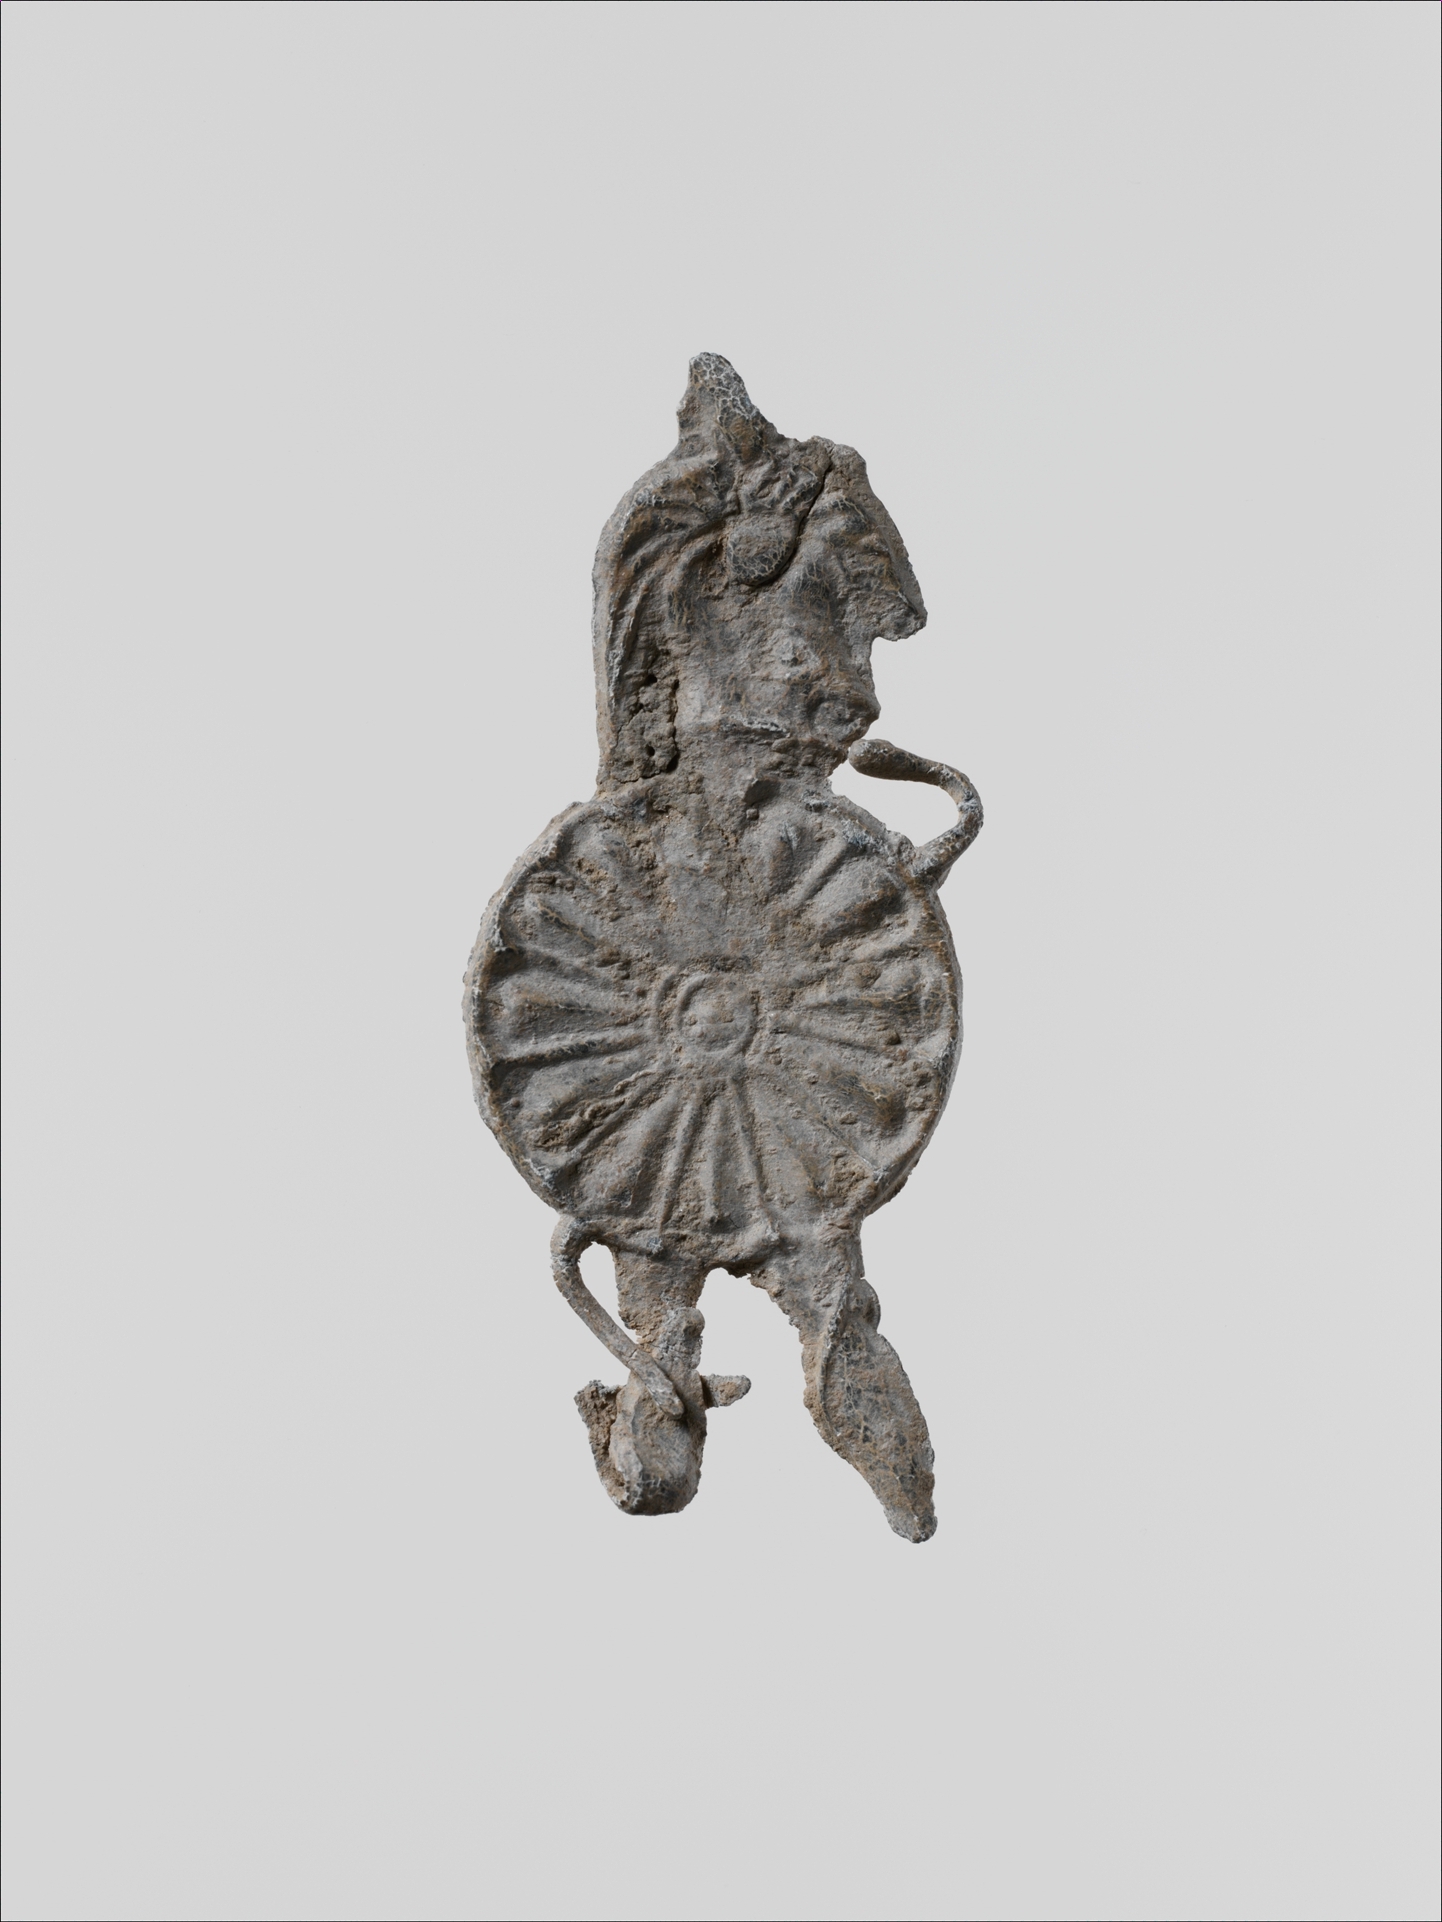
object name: statuette of a warrior, 10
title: Lead figure of a warrior with a helmet, shield, and spear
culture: greek, laconian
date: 600-401 BCE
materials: lead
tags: soldiers,helmets,shields